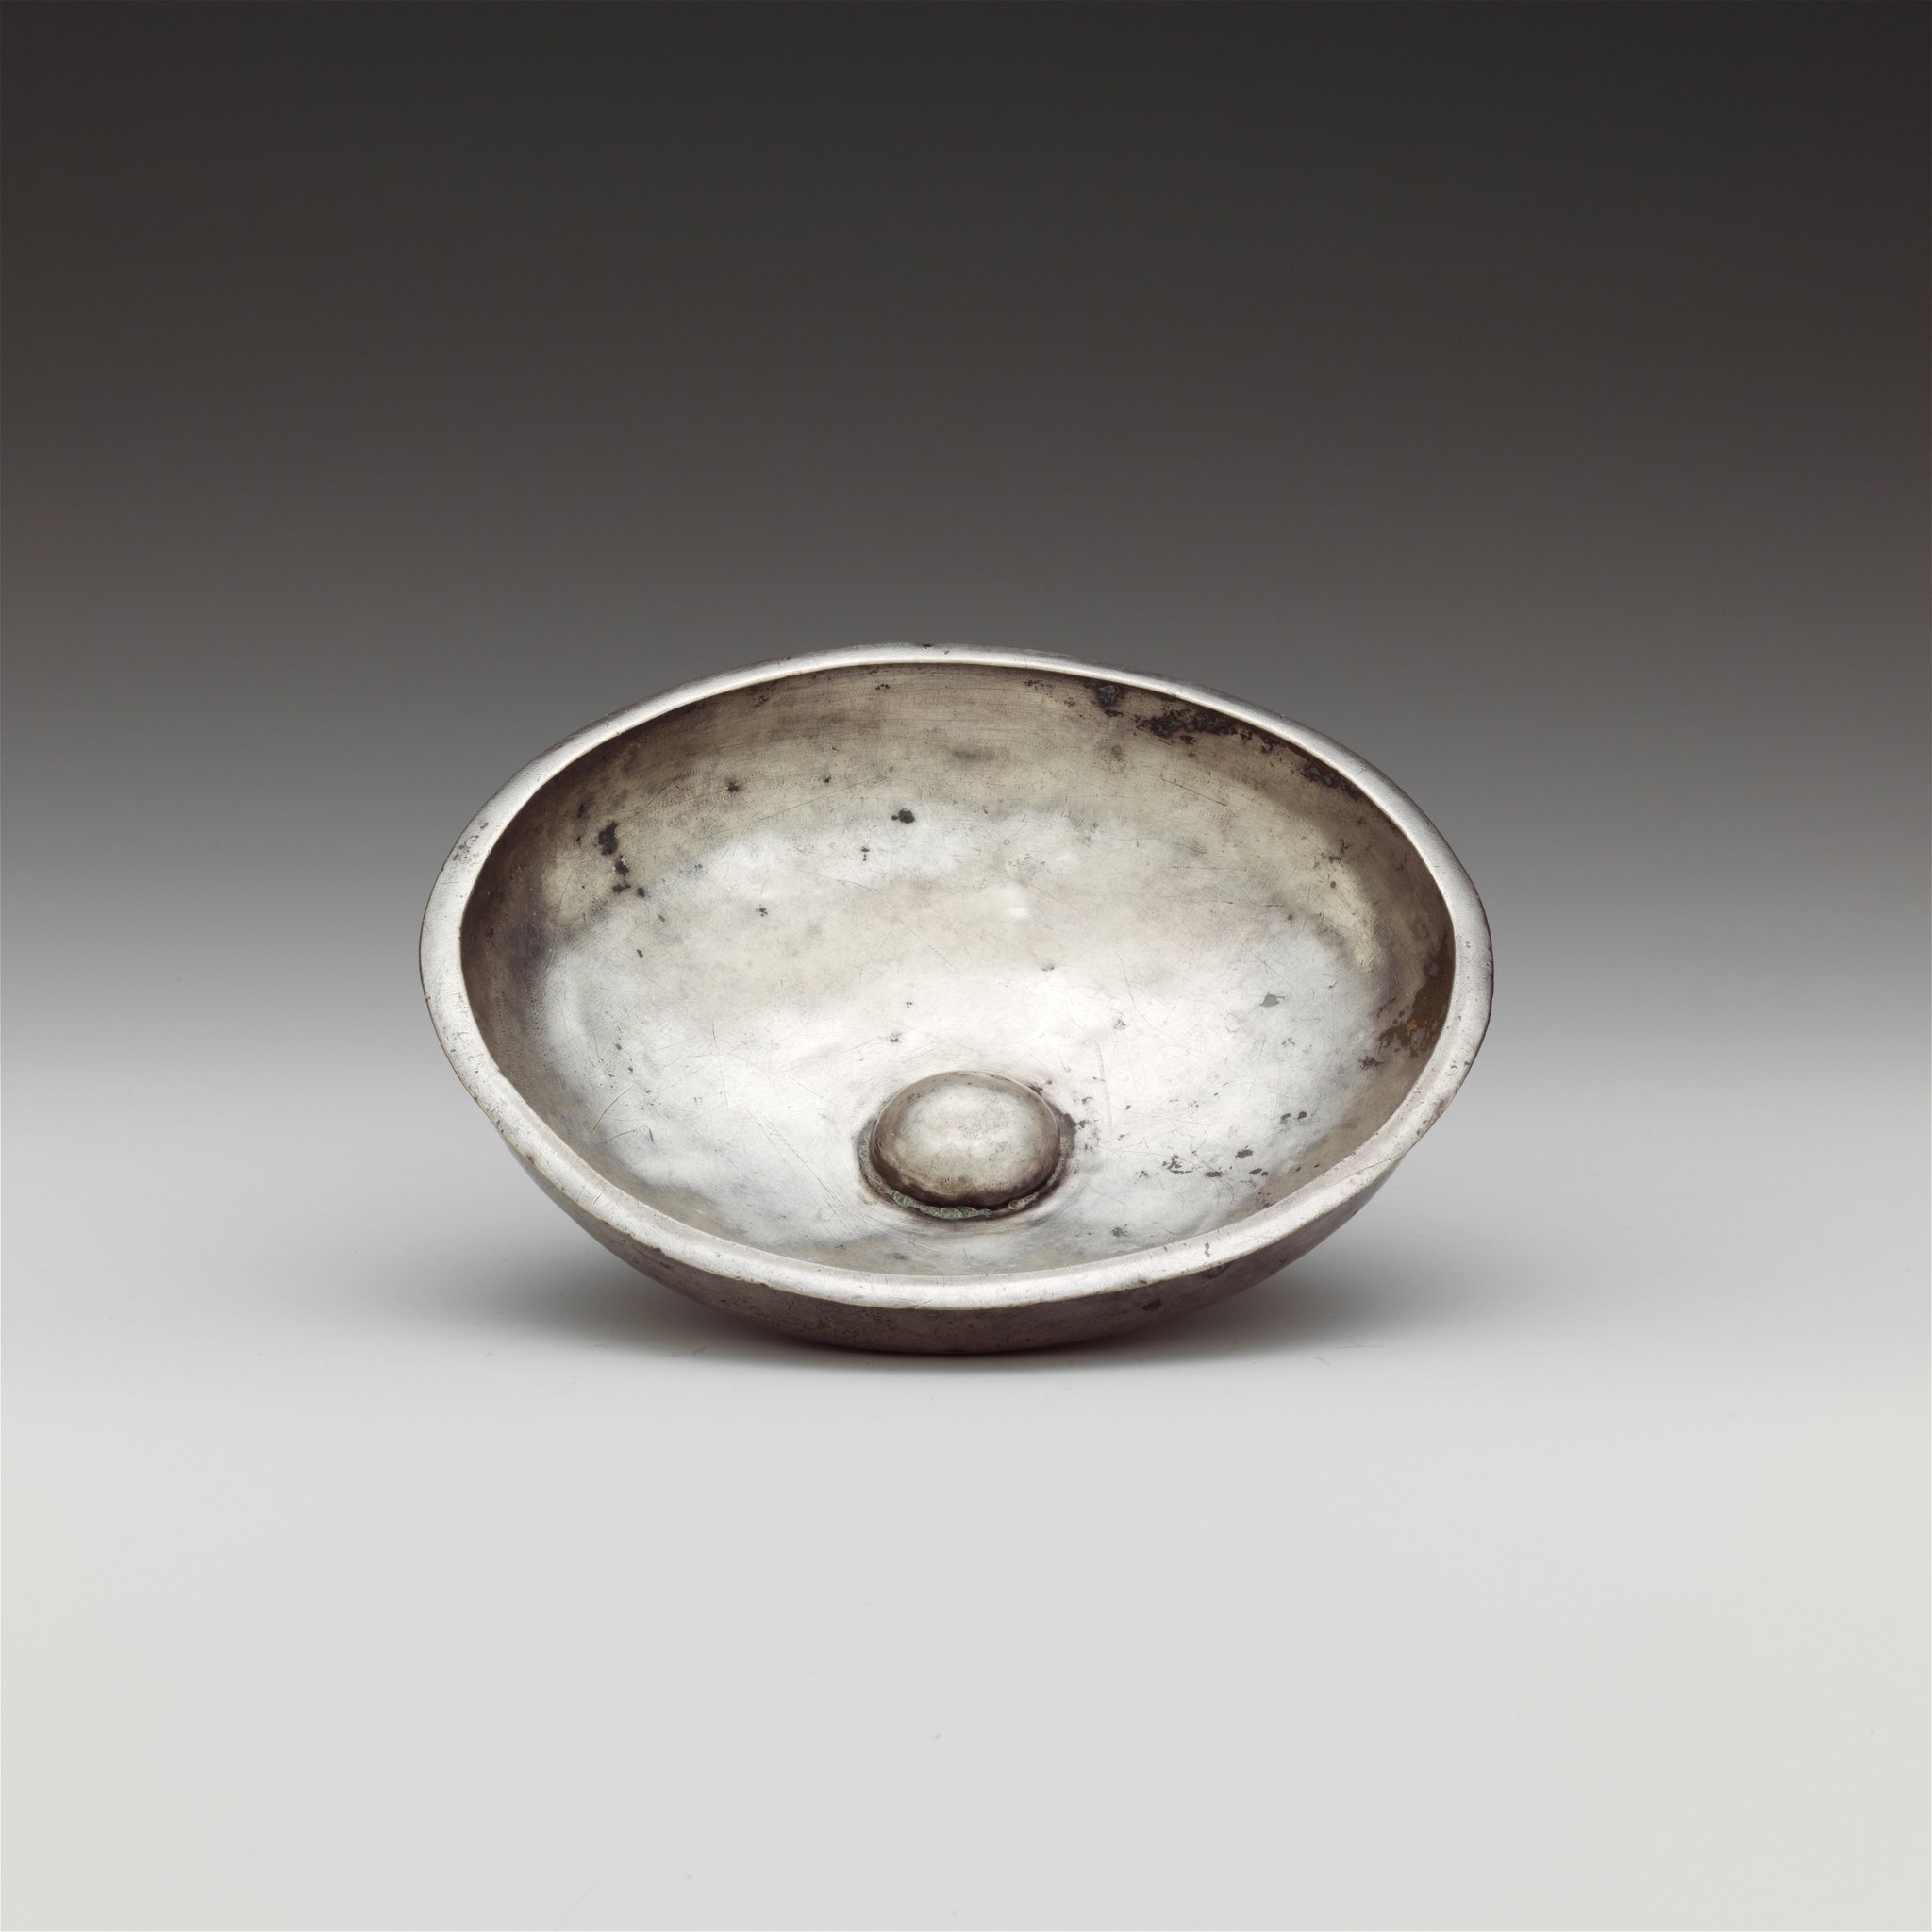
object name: phiale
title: Silver phiale (libation bowl)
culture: anatolian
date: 2300-2000 BCE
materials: silver